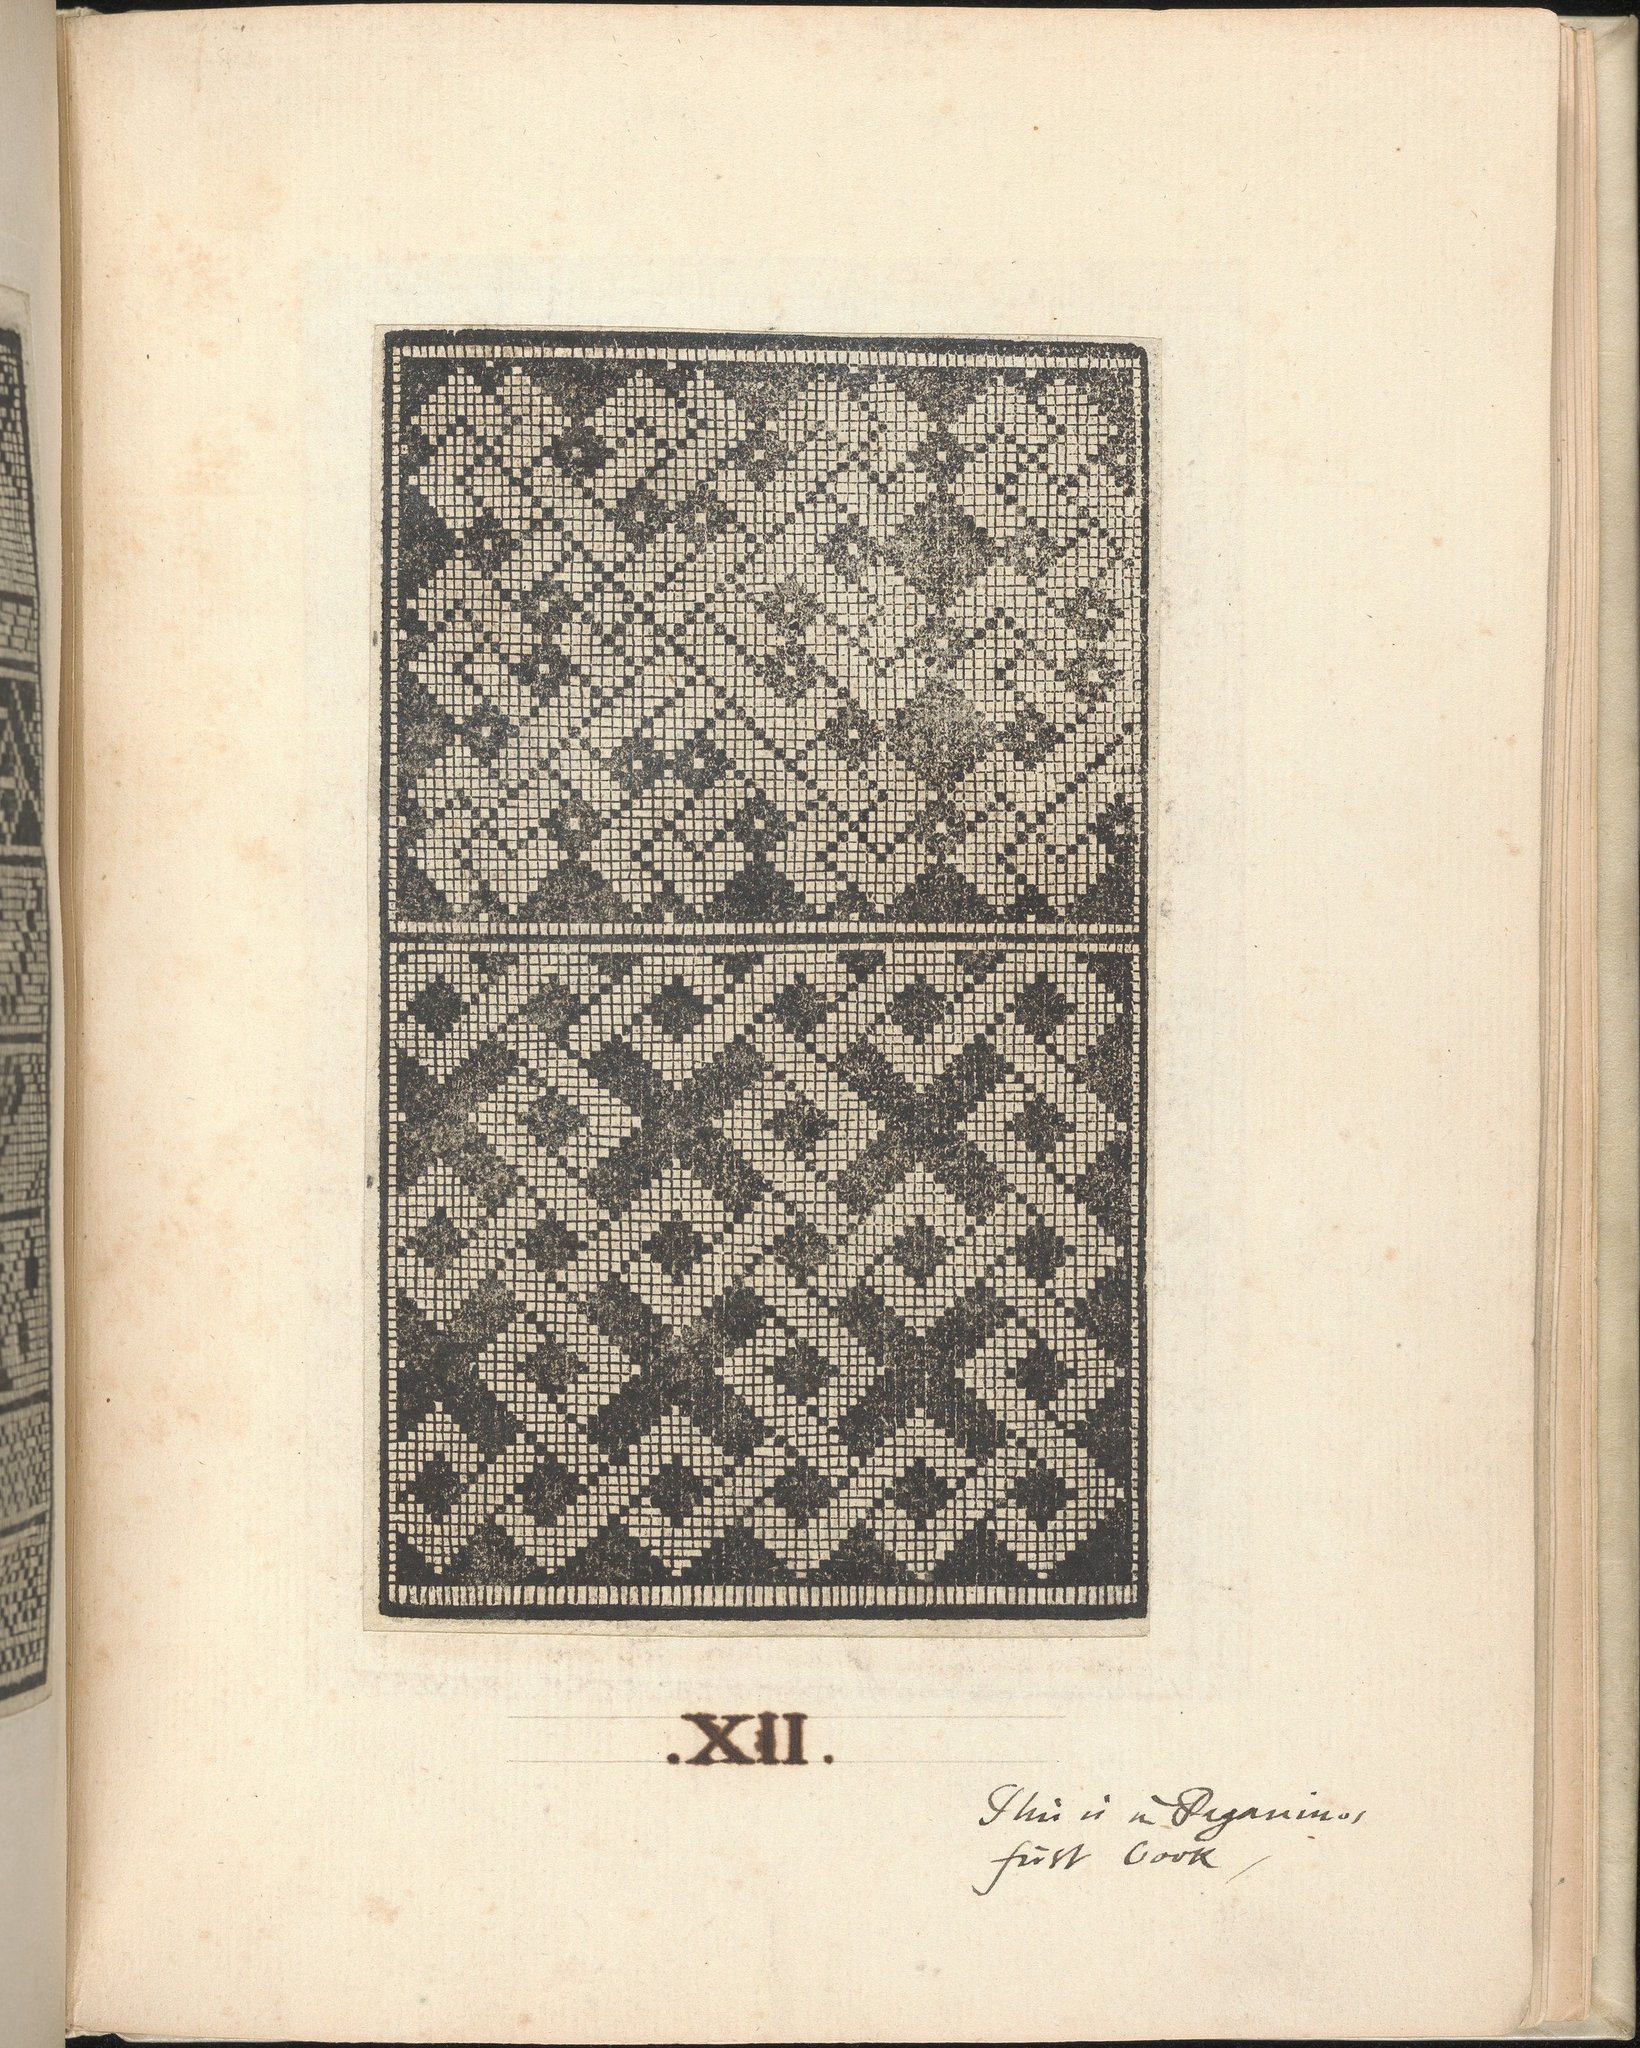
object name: book print ornament architecture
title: Esemplario di lavori, page 12 (recto)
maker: nicolò zoppino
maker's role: publisher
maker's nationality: italian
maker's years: 1478-1544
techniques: bookbinding, inlay, woodcut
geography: italy